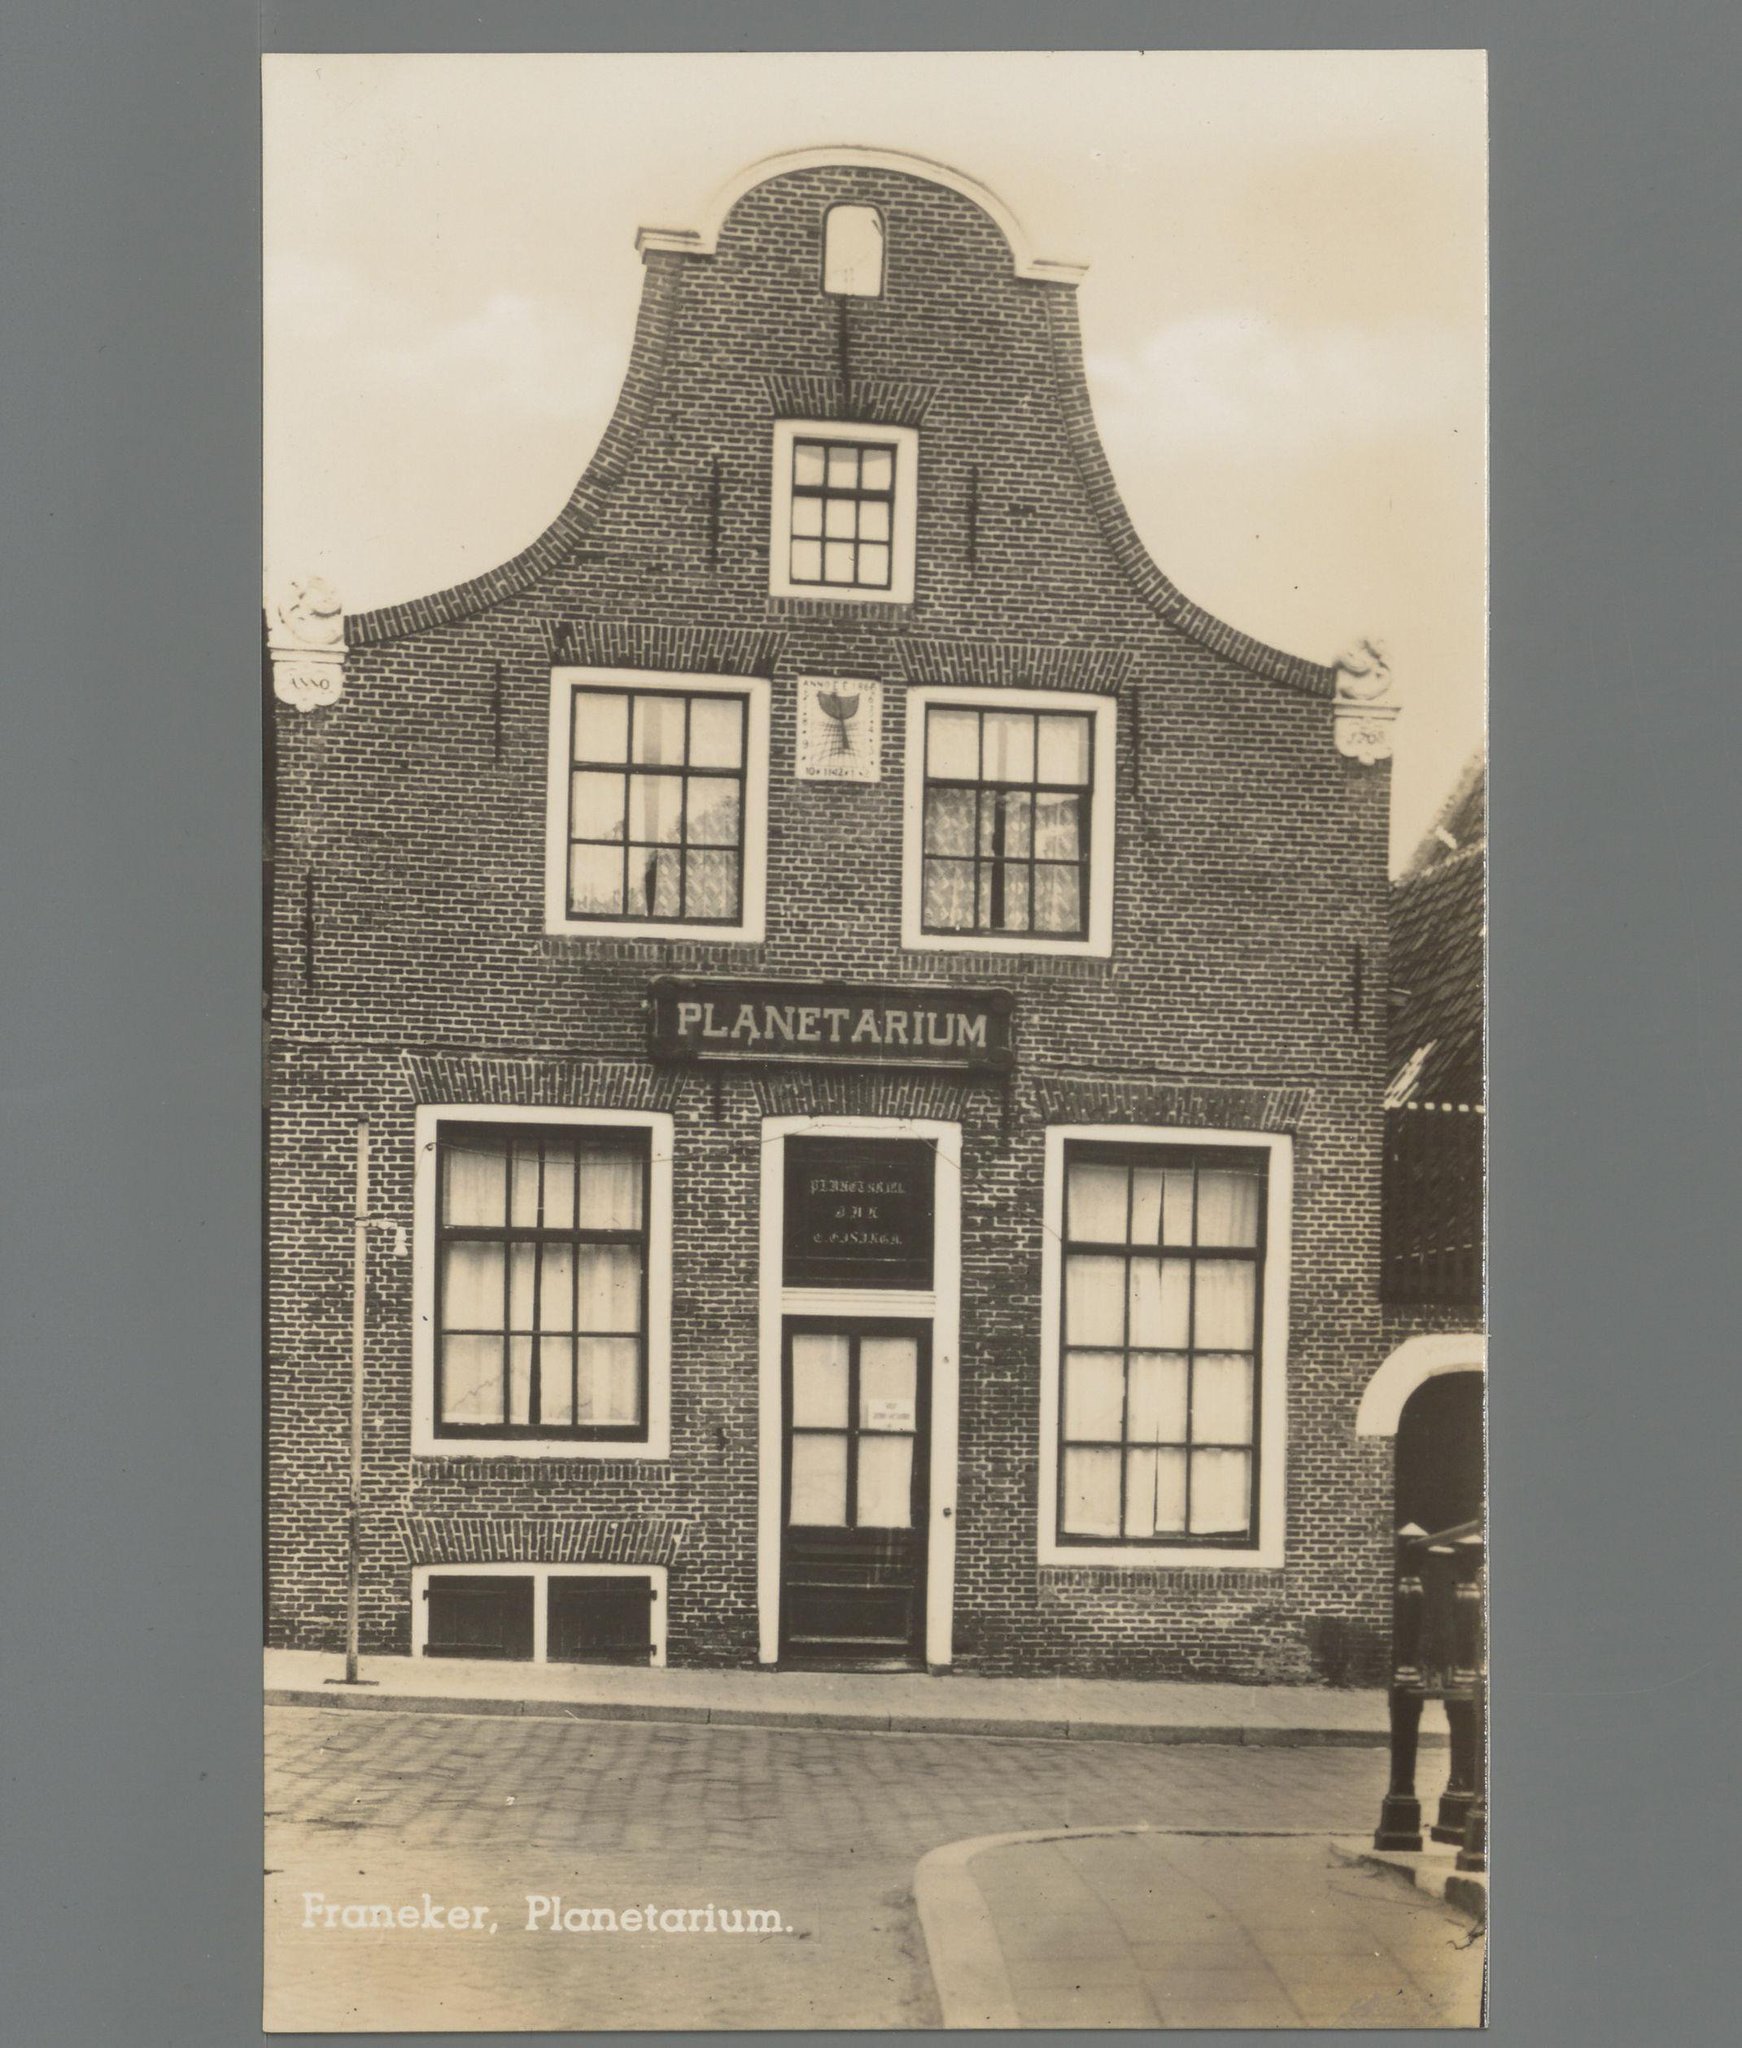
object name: photograph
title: Franeker, Planetarium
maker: Anonymous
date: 1943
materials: photographic support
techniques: photography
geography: franeker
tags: orrery, planetarium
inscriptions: number: ‘1943’